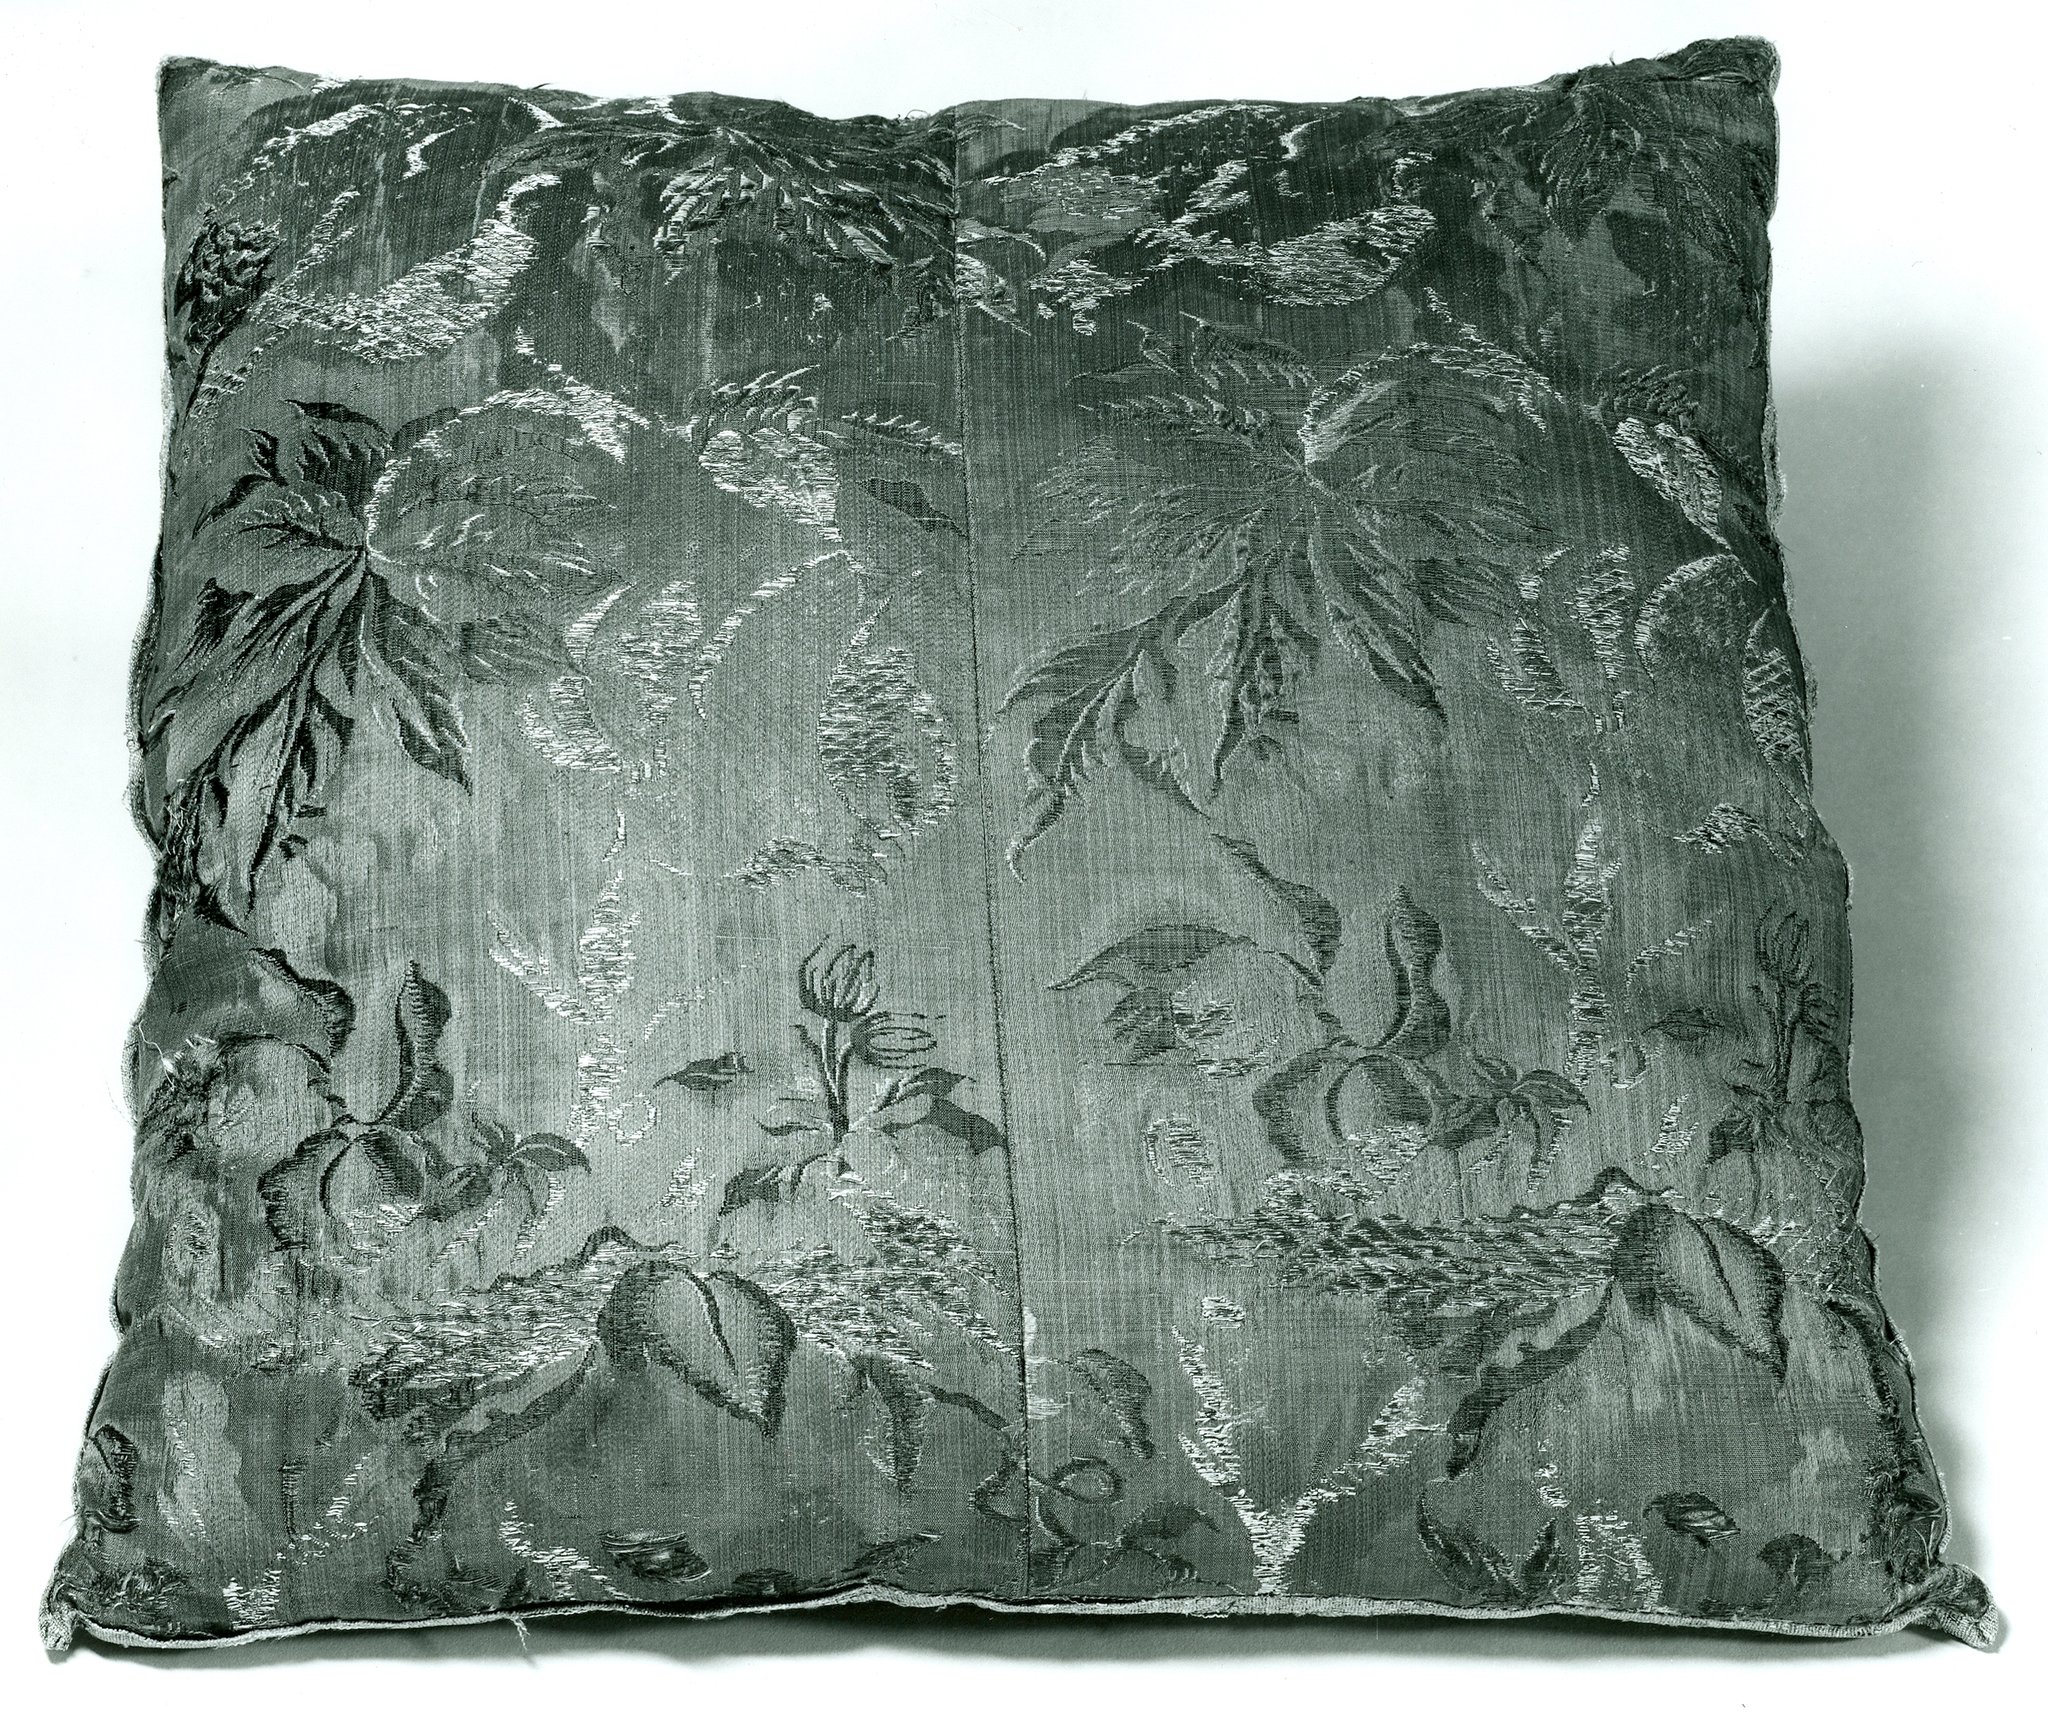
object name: cushion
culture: italian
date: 1601-1700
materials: linen, metal, silk